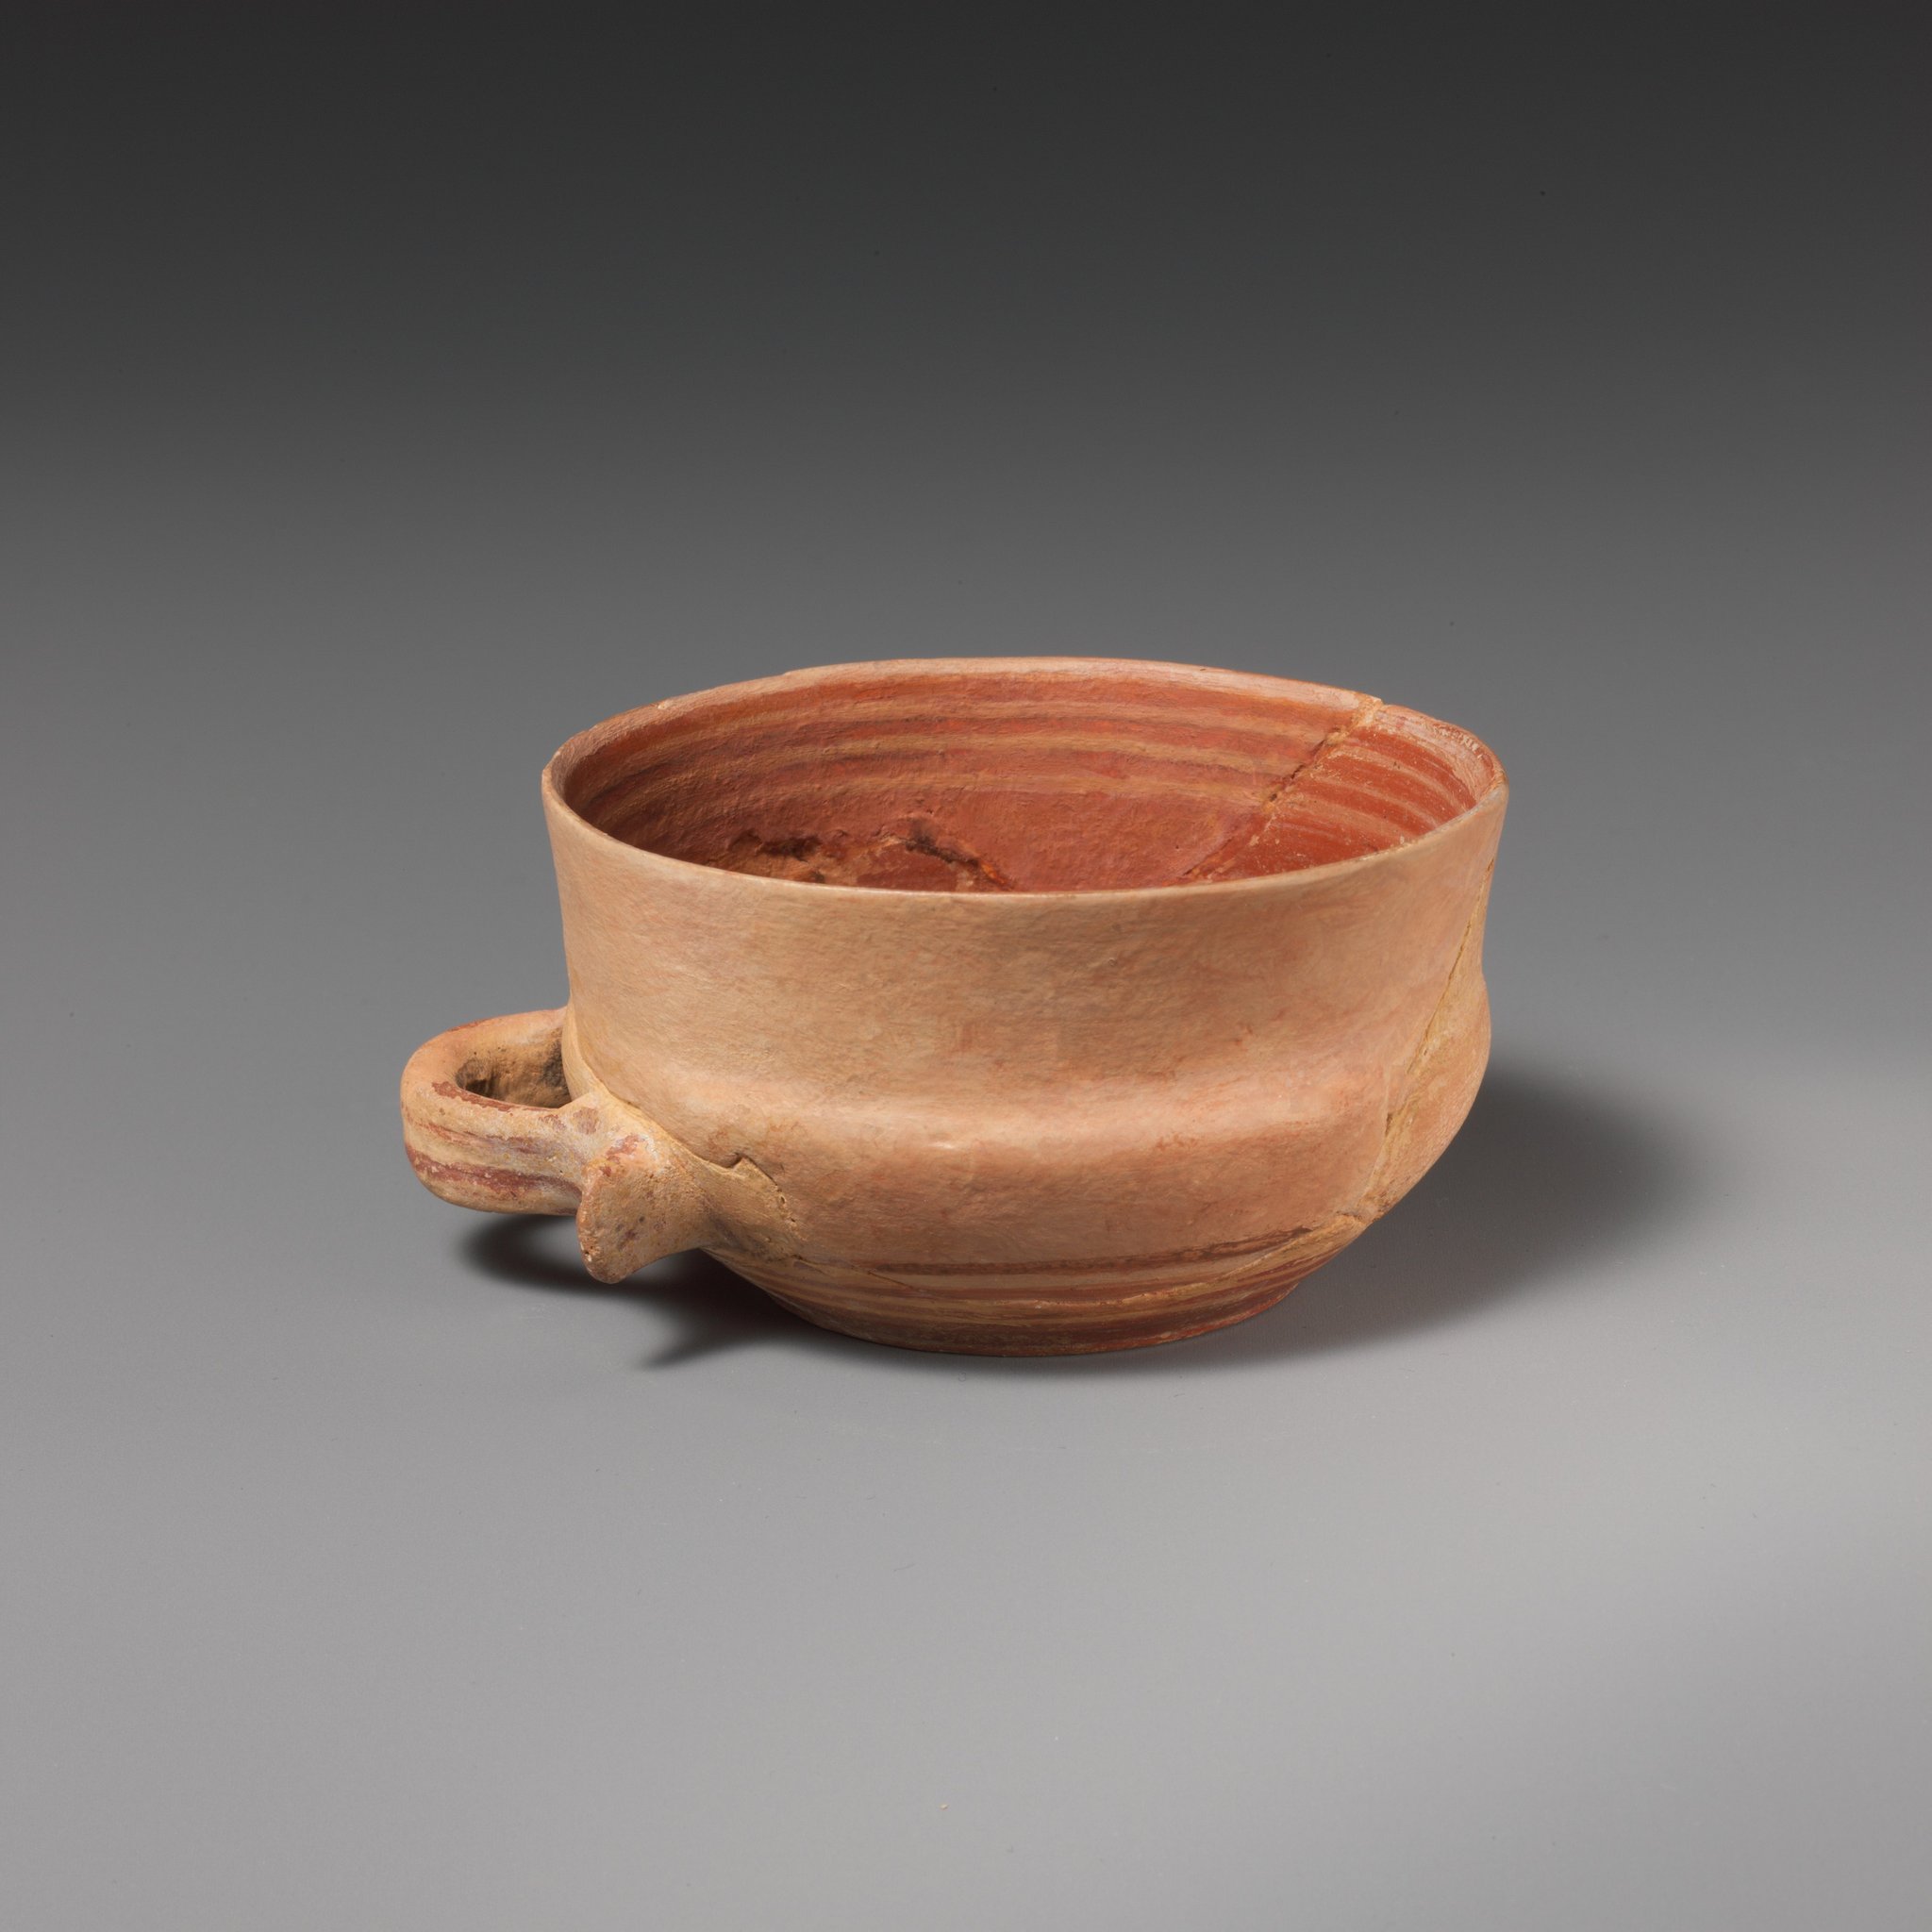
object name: lekane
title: Terracotta lekane (dish)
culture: greek, attic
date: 734-701 BCE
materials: terracotta